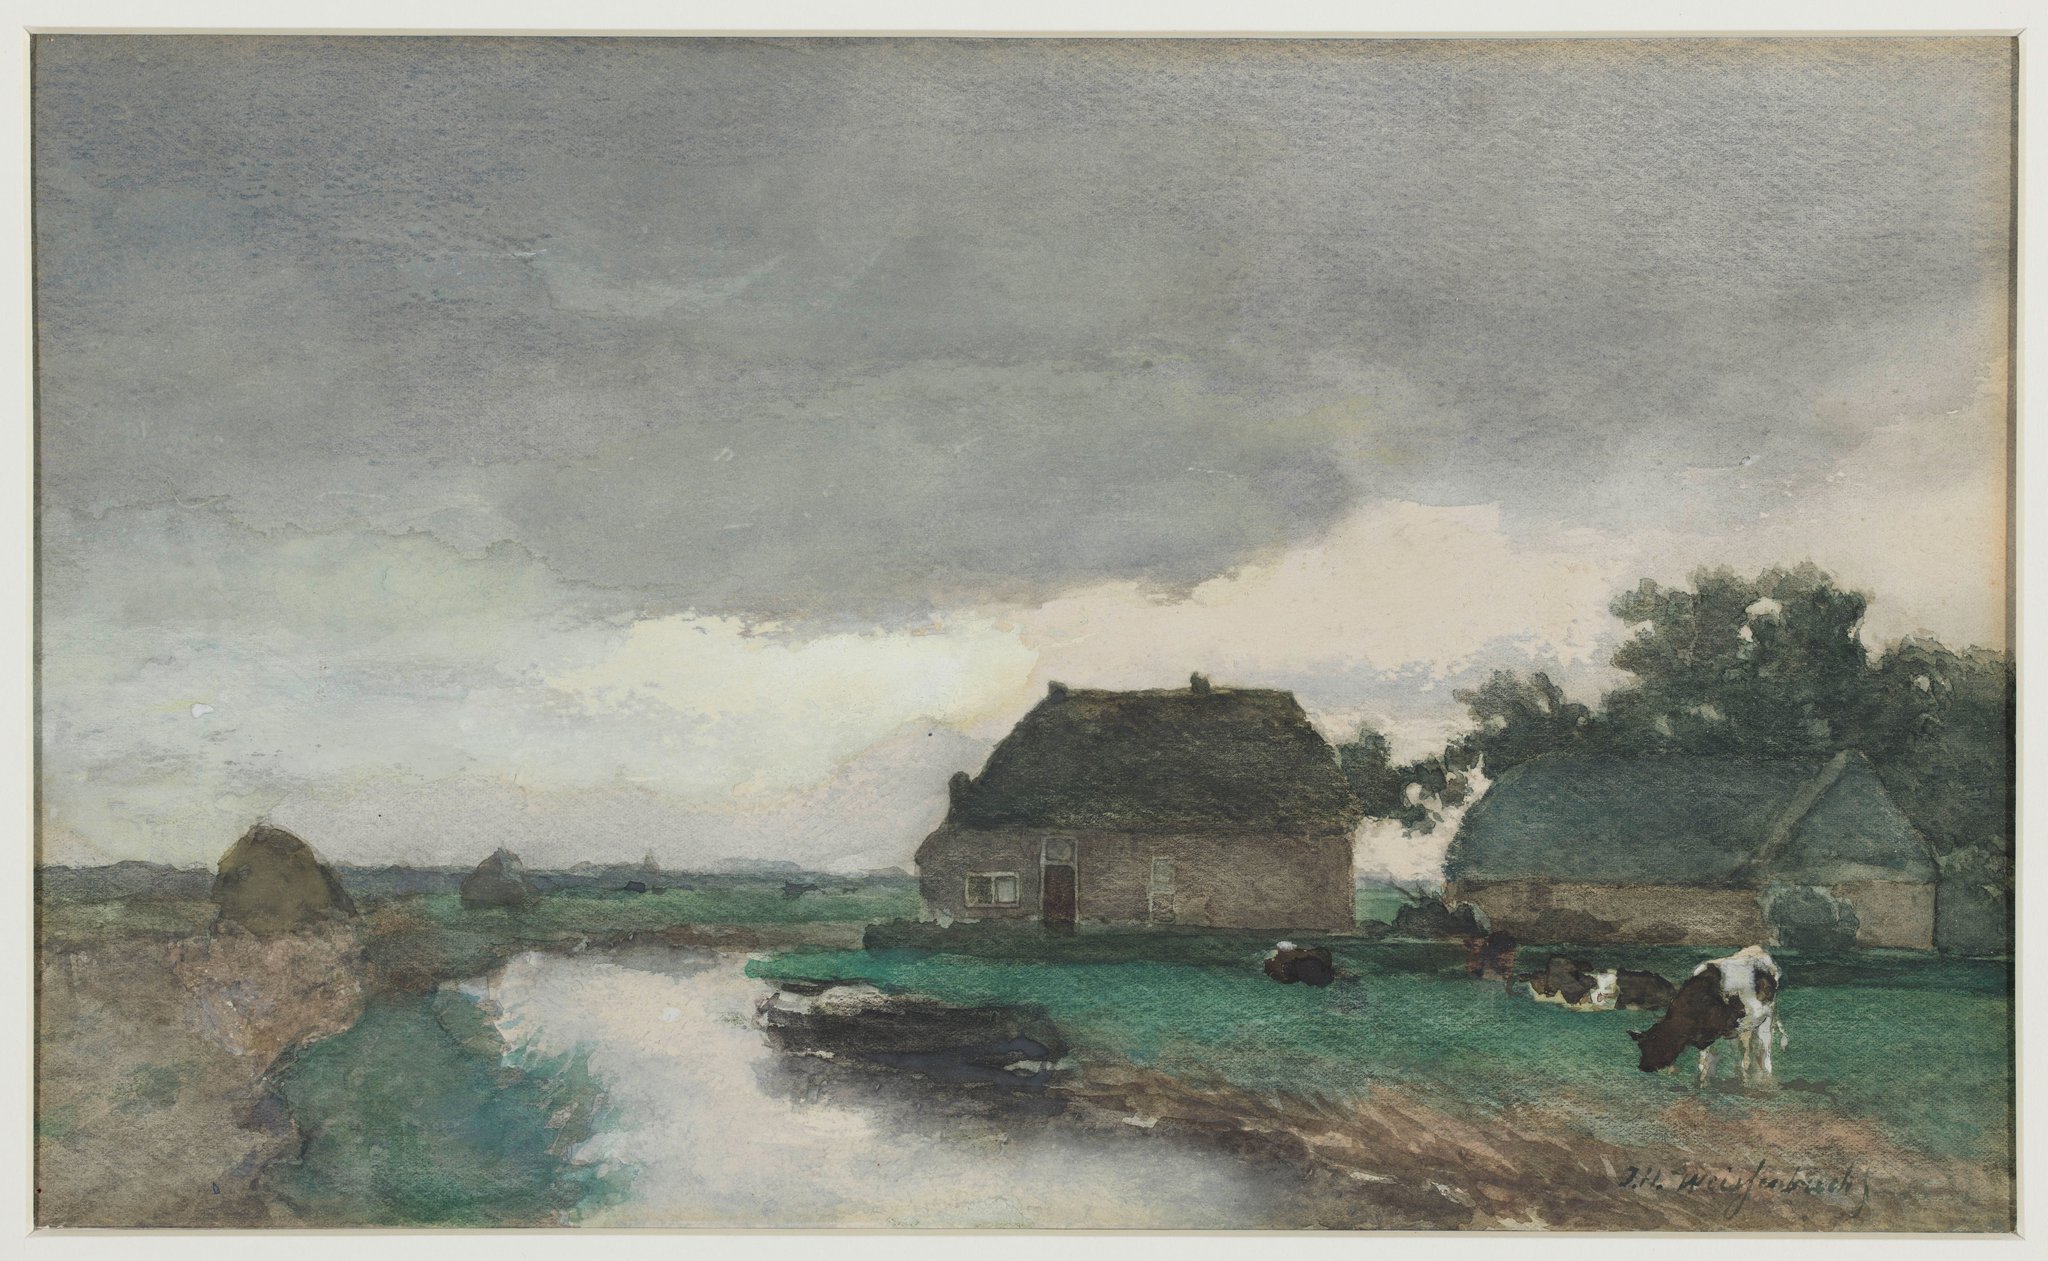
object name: watercolor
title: Boerderij met schuur aan een vaart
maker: johan hendrik weissenbruch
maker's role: draughtsman, painter, print maker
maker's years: 1824-1903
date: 1834-1903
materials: paper, watercolor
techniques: brush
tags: river, meadow, pasture, farm or solitary house in landscape